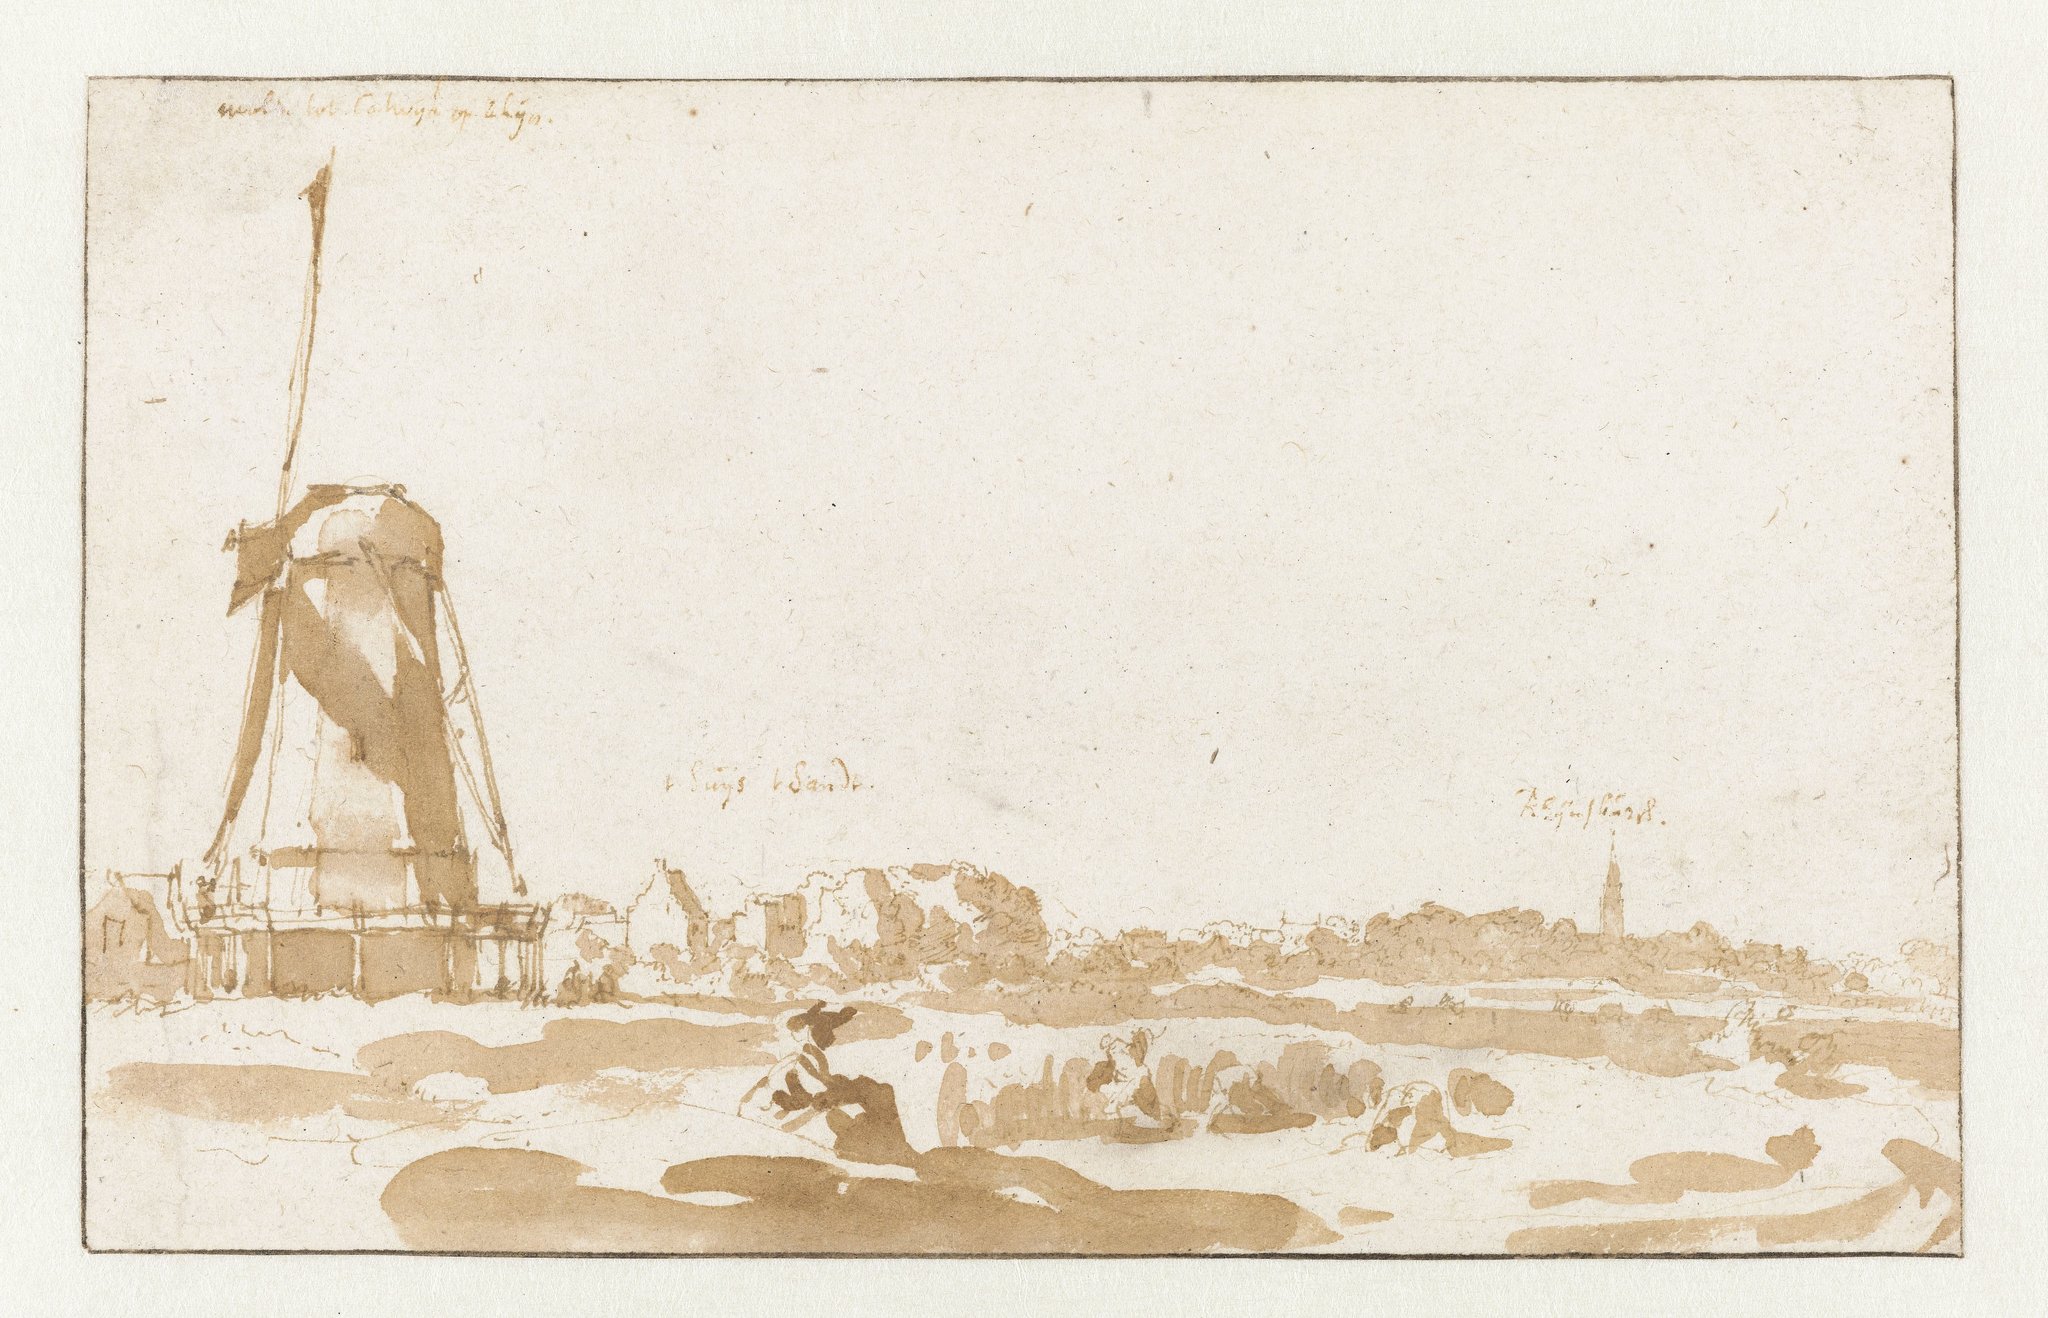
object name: drawing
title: Gezicht op een molen vanaf de Rijnoever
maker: jan de bisschop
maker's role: draughtsman, print maker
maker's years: 1628-1671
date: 1648-1671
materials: ink, paper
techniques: brush, pen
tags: windmill in landscape, windmill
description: Gezicht vanaf de westelijke Rijnoever ten zuiden van Katwijk aan de Rijn op de daar gelegen molen; op de achtergrond het Zand en de torenspits van Rijnsburg.